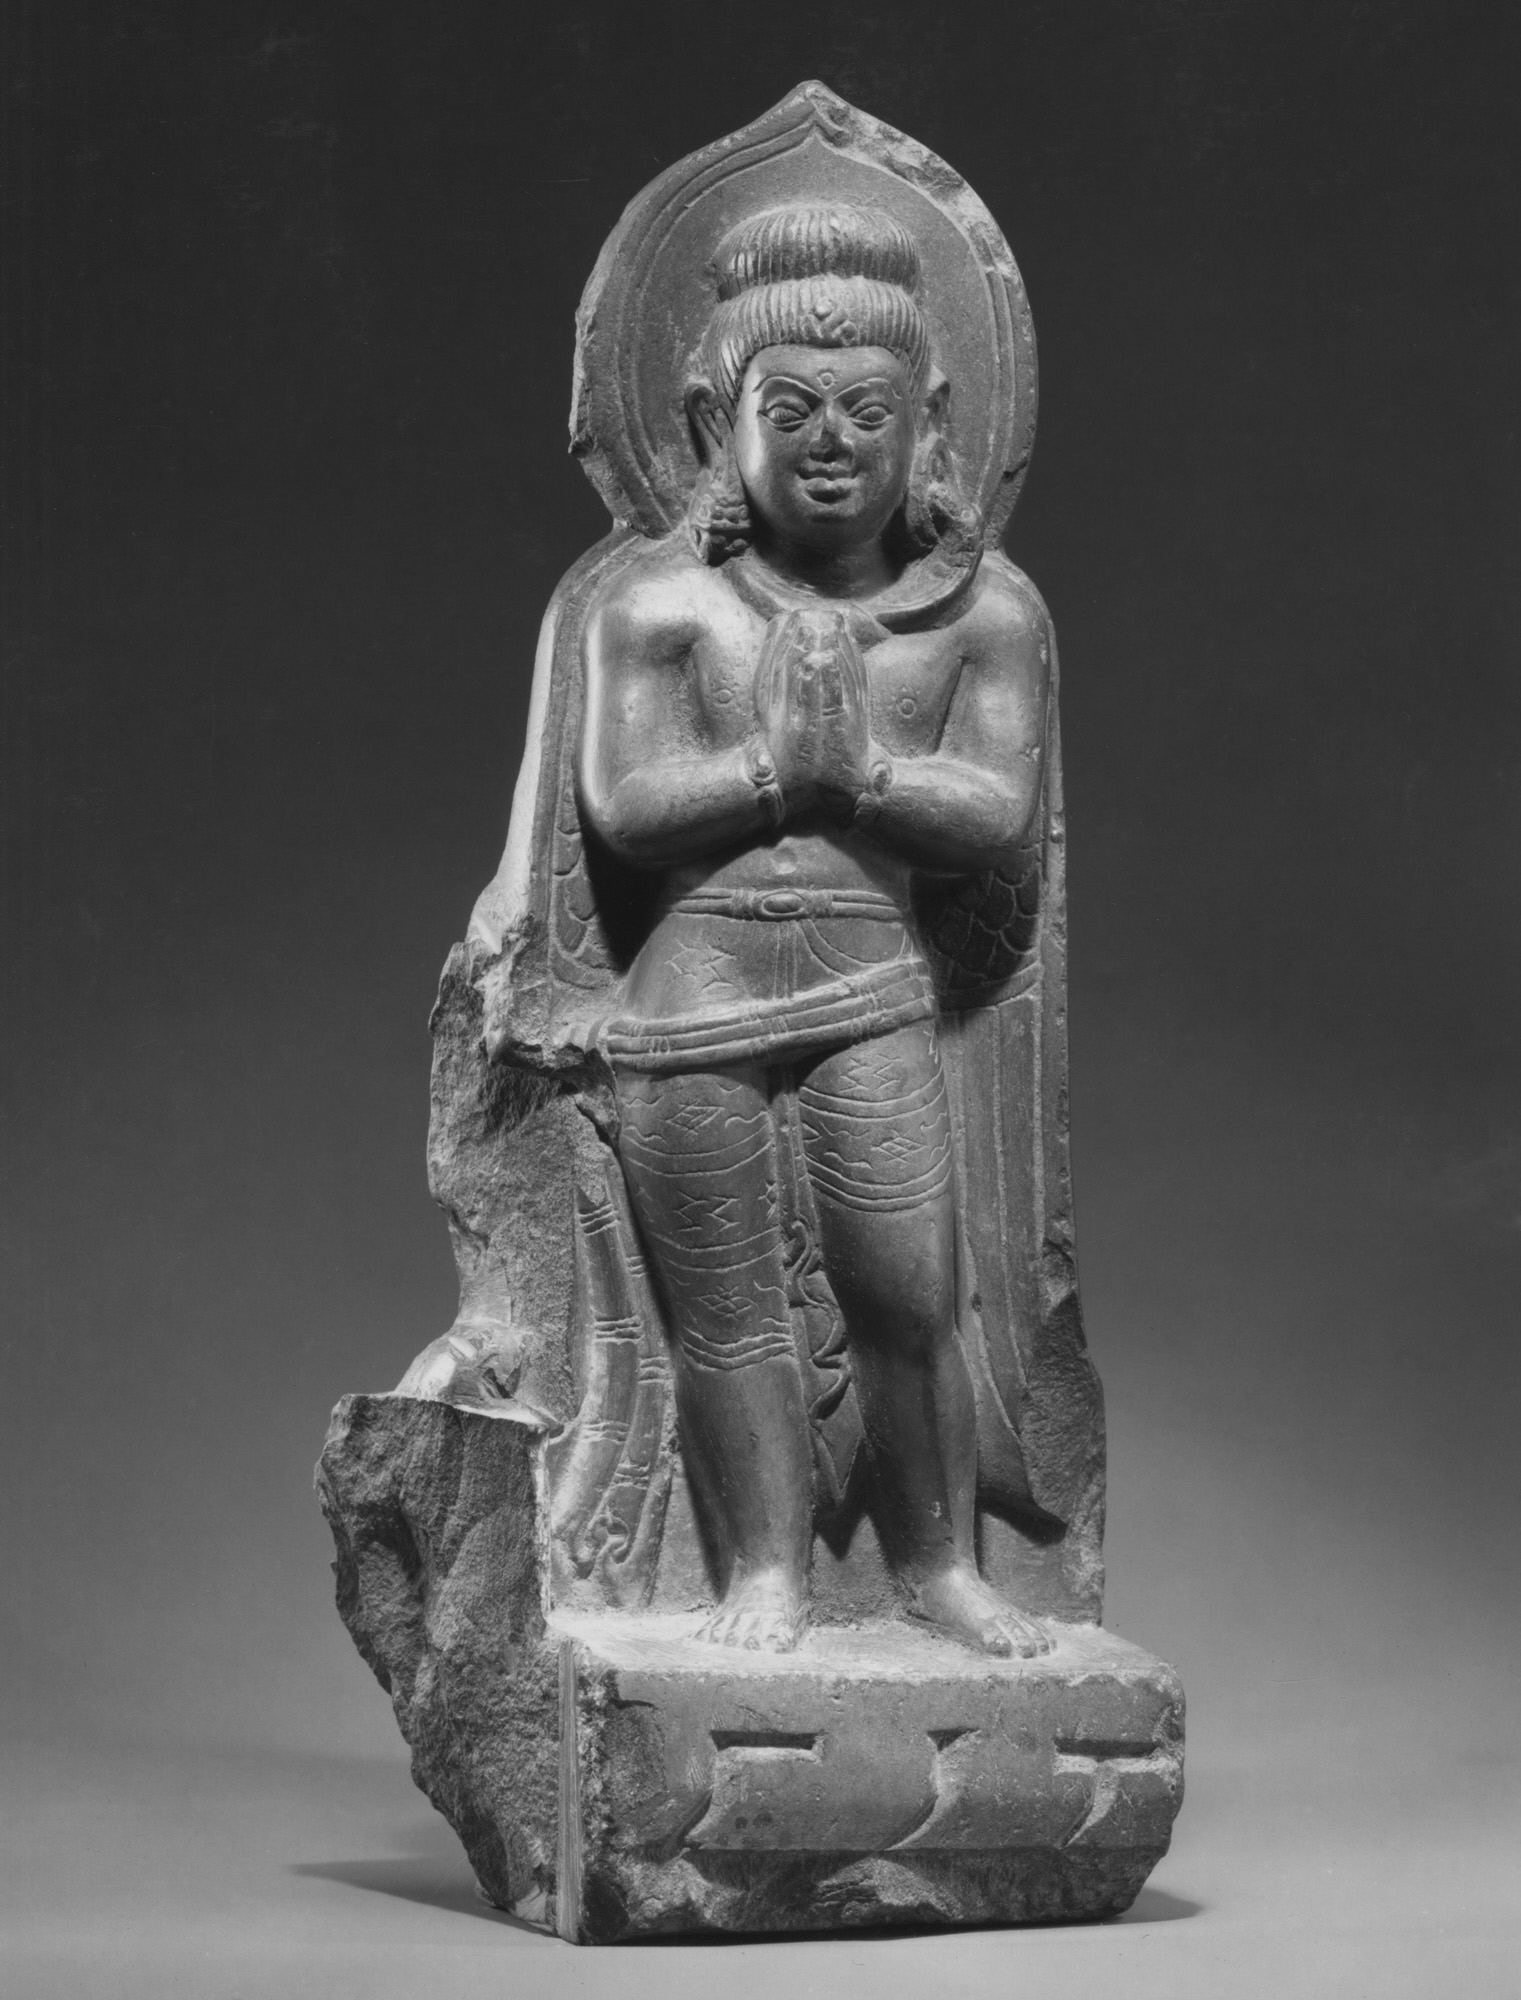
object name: figure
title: Standing Garuda (The Royal Solar Bird)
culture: nepali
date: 801-1000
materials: stone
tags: hinduism